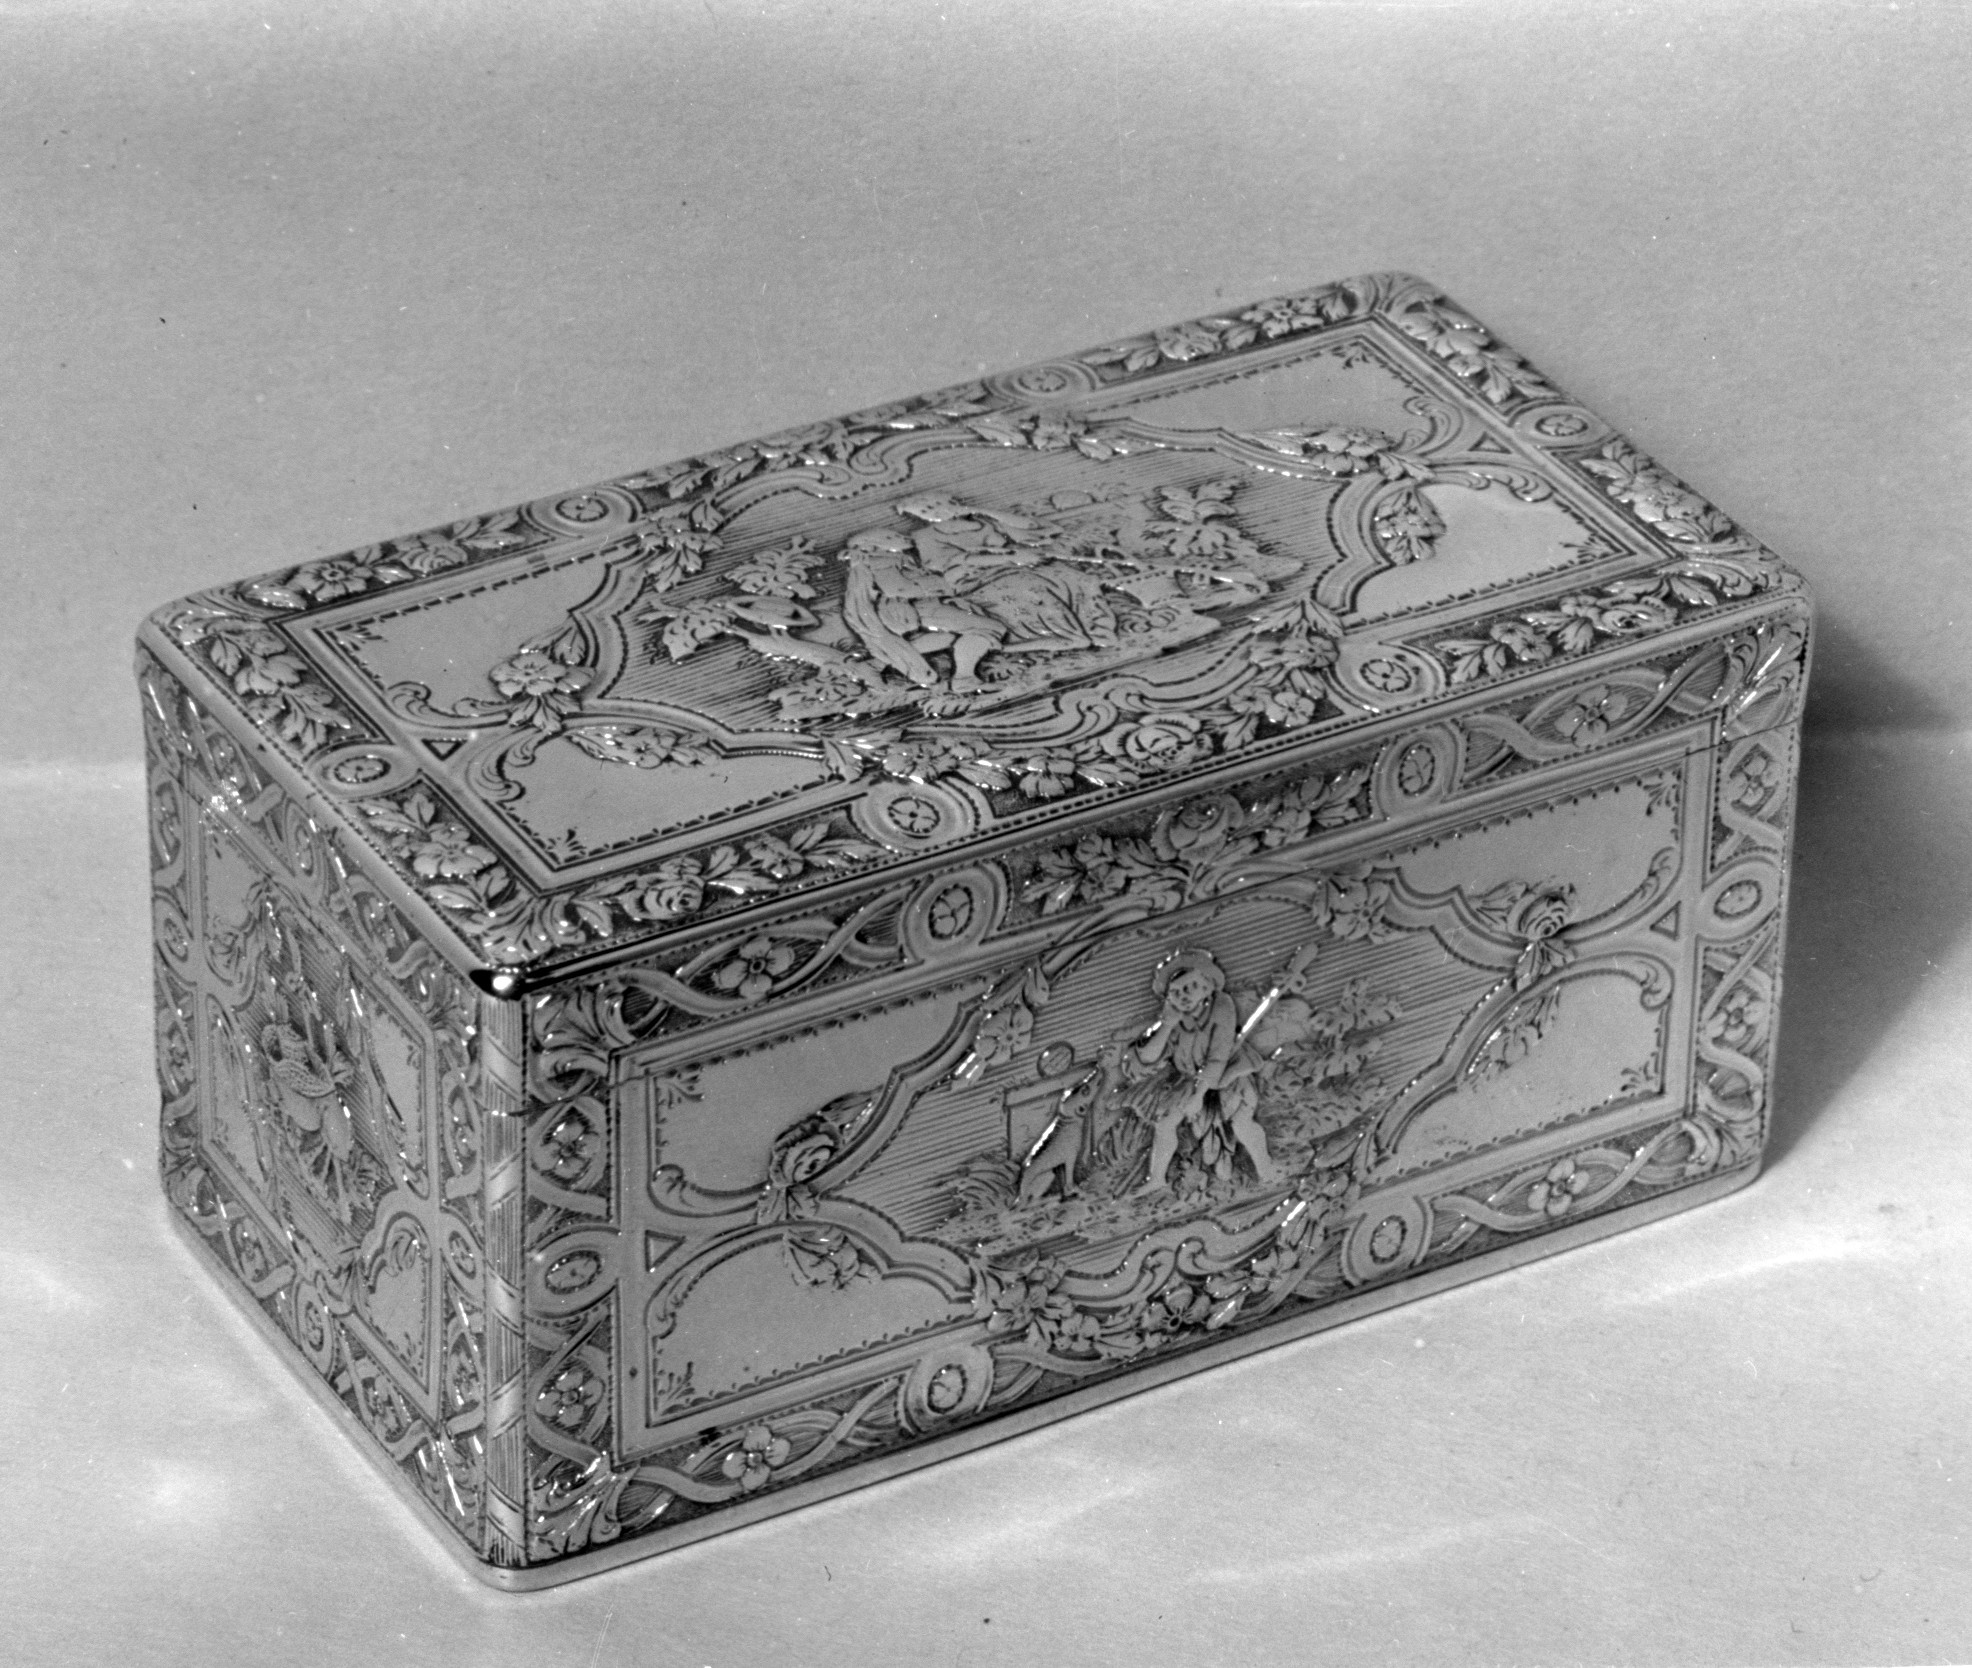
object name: snuffbox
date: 1770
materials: gold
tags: human figures,animals,flowers